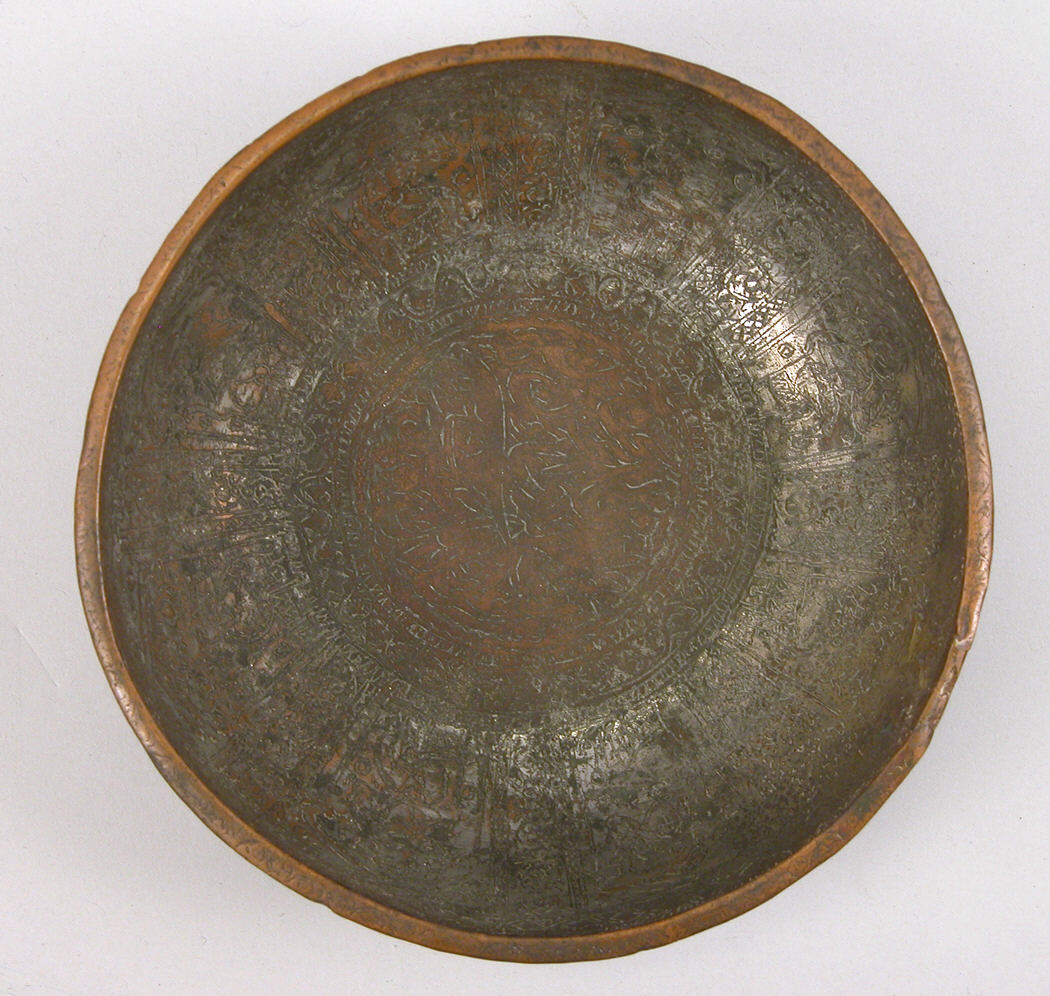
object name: bowl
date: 1701-1900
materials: copper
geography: india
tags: flowers